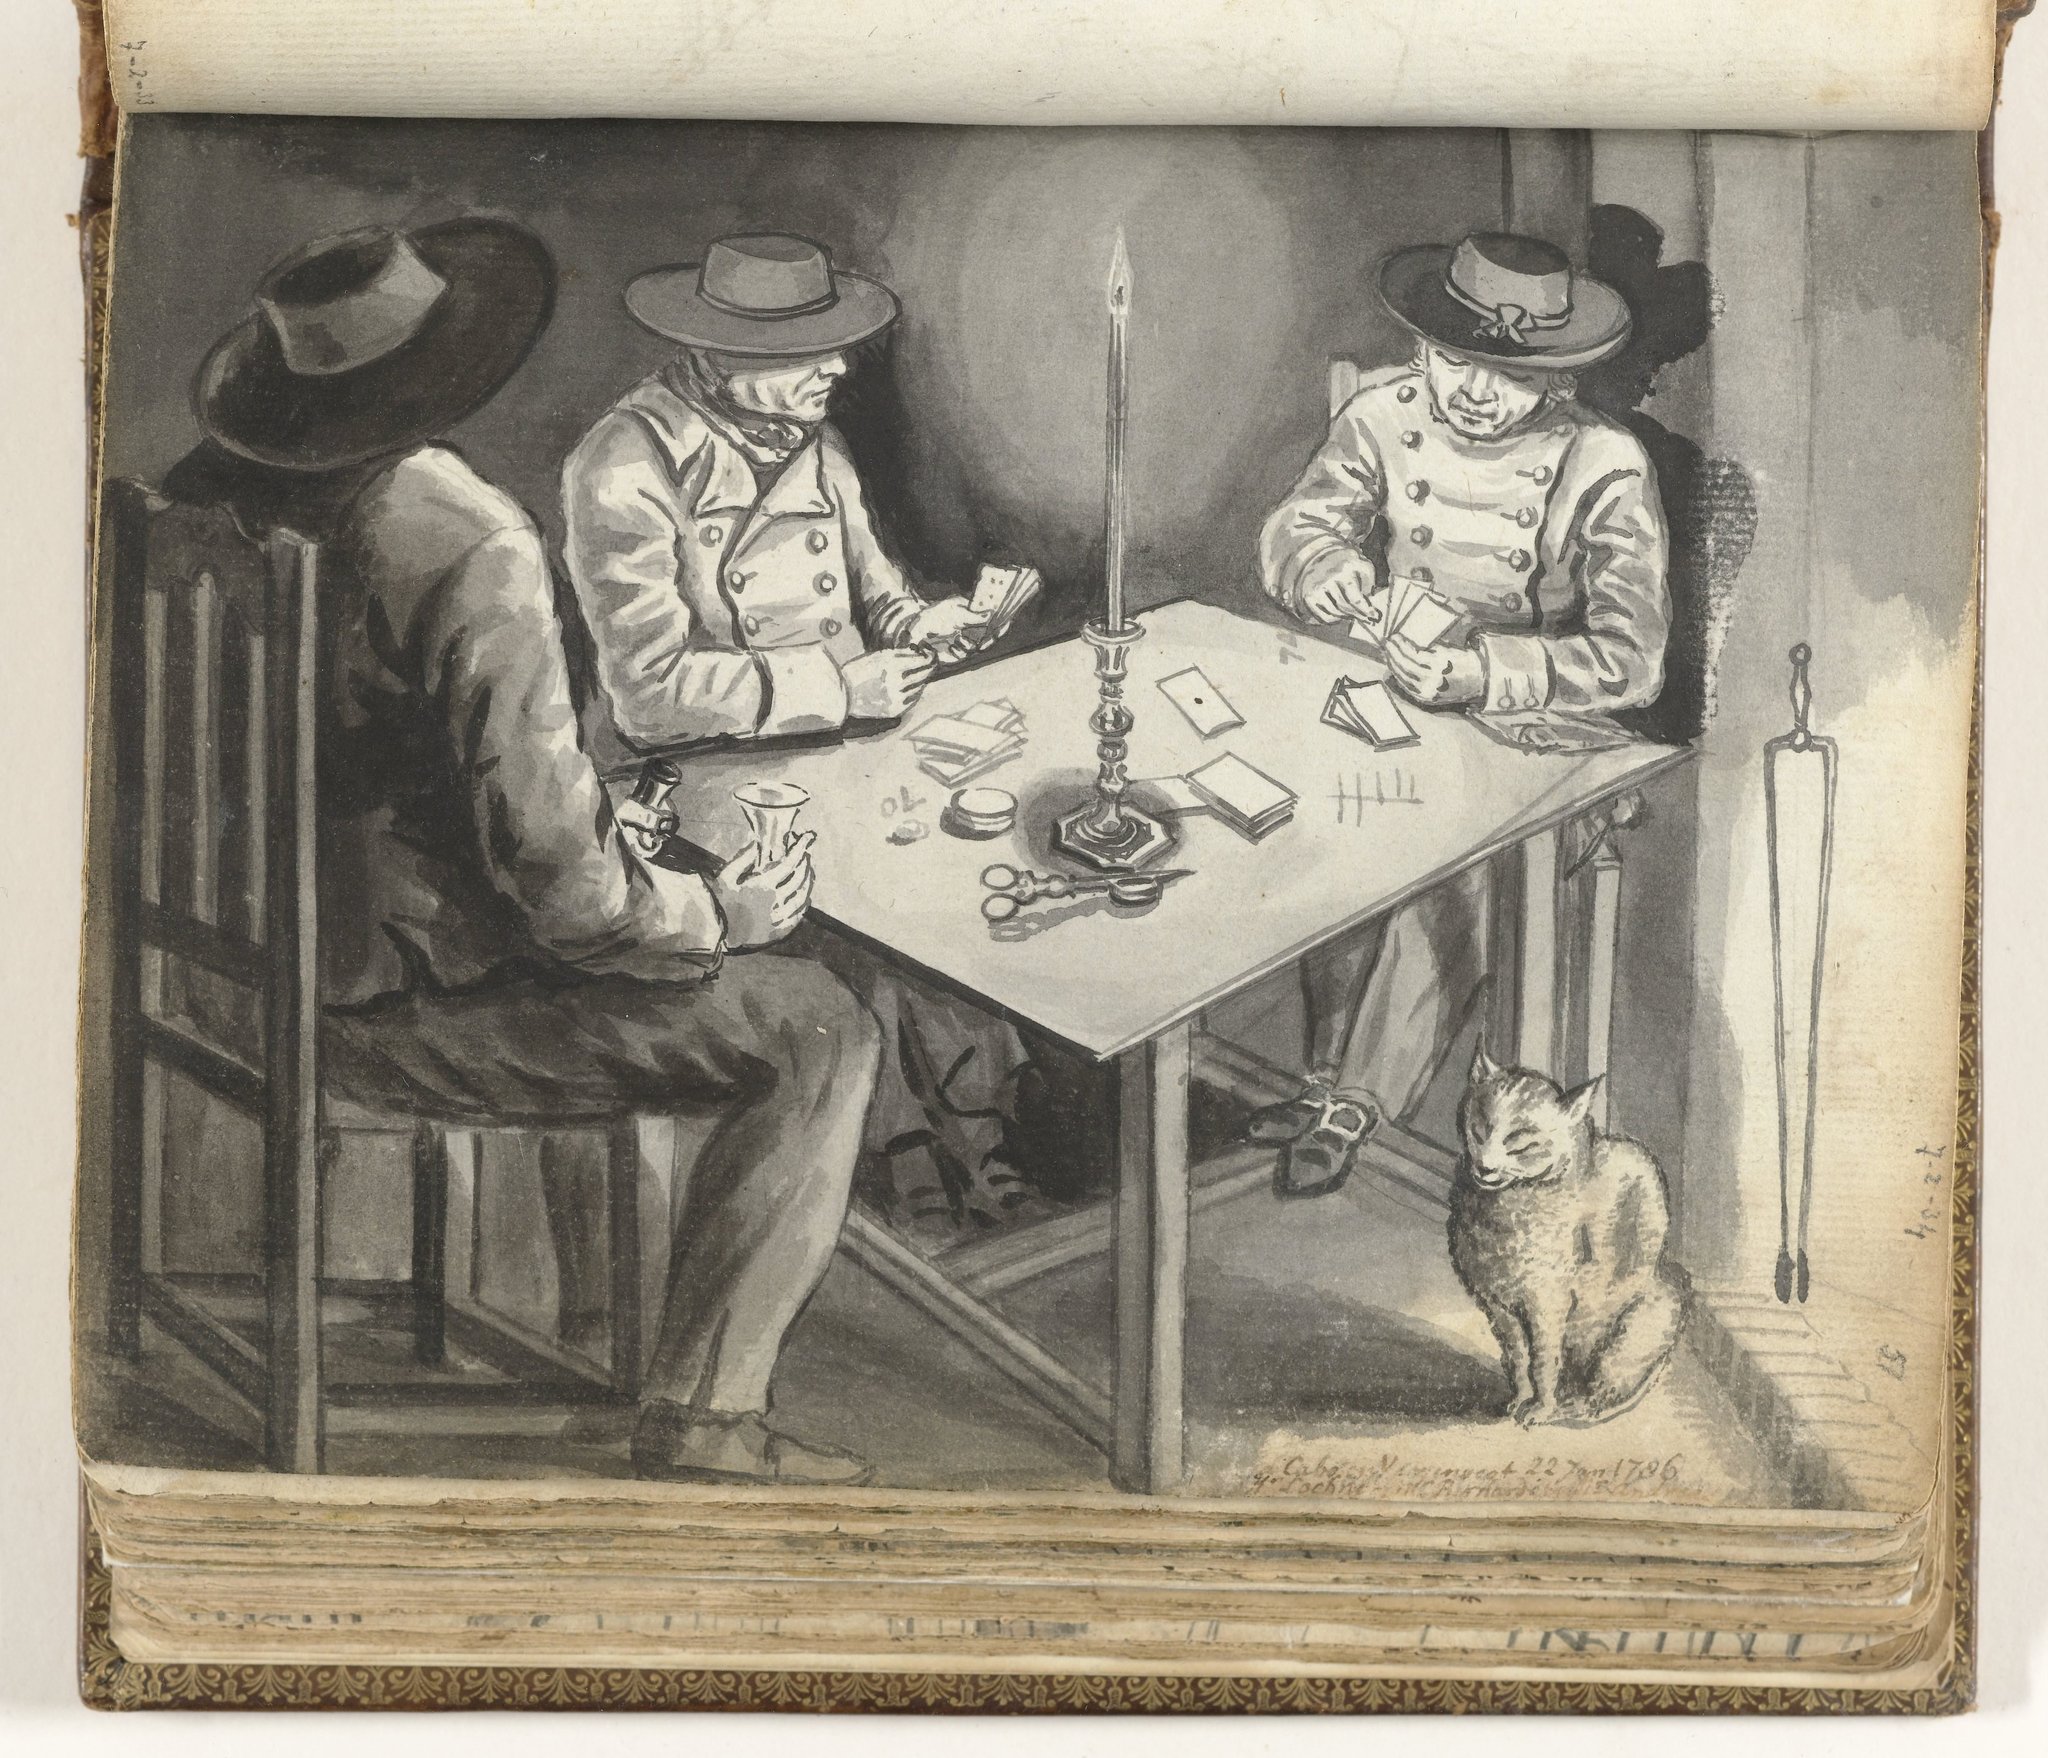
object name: drawing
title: Kaartavond bij Lochner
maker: jan brandes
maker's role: draughtsman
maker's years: 1743-1808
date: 1787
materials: paper, pencil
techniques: brush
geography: cape of good hope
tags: card games, candle, cape of good hope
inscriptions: inscription: ‘Cabo op Vergenoegt 22 Jan 1786; Hr Lochner, MC Barnardi [en] MB Andreas’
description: Zwartwittekening van drie mannen rond een tafel met een kandelaar bij een haardvuur. Met opschrift. Onderdeel uit het schetsboek van Jan Brandes, dl. 2 (1808), p. 51.